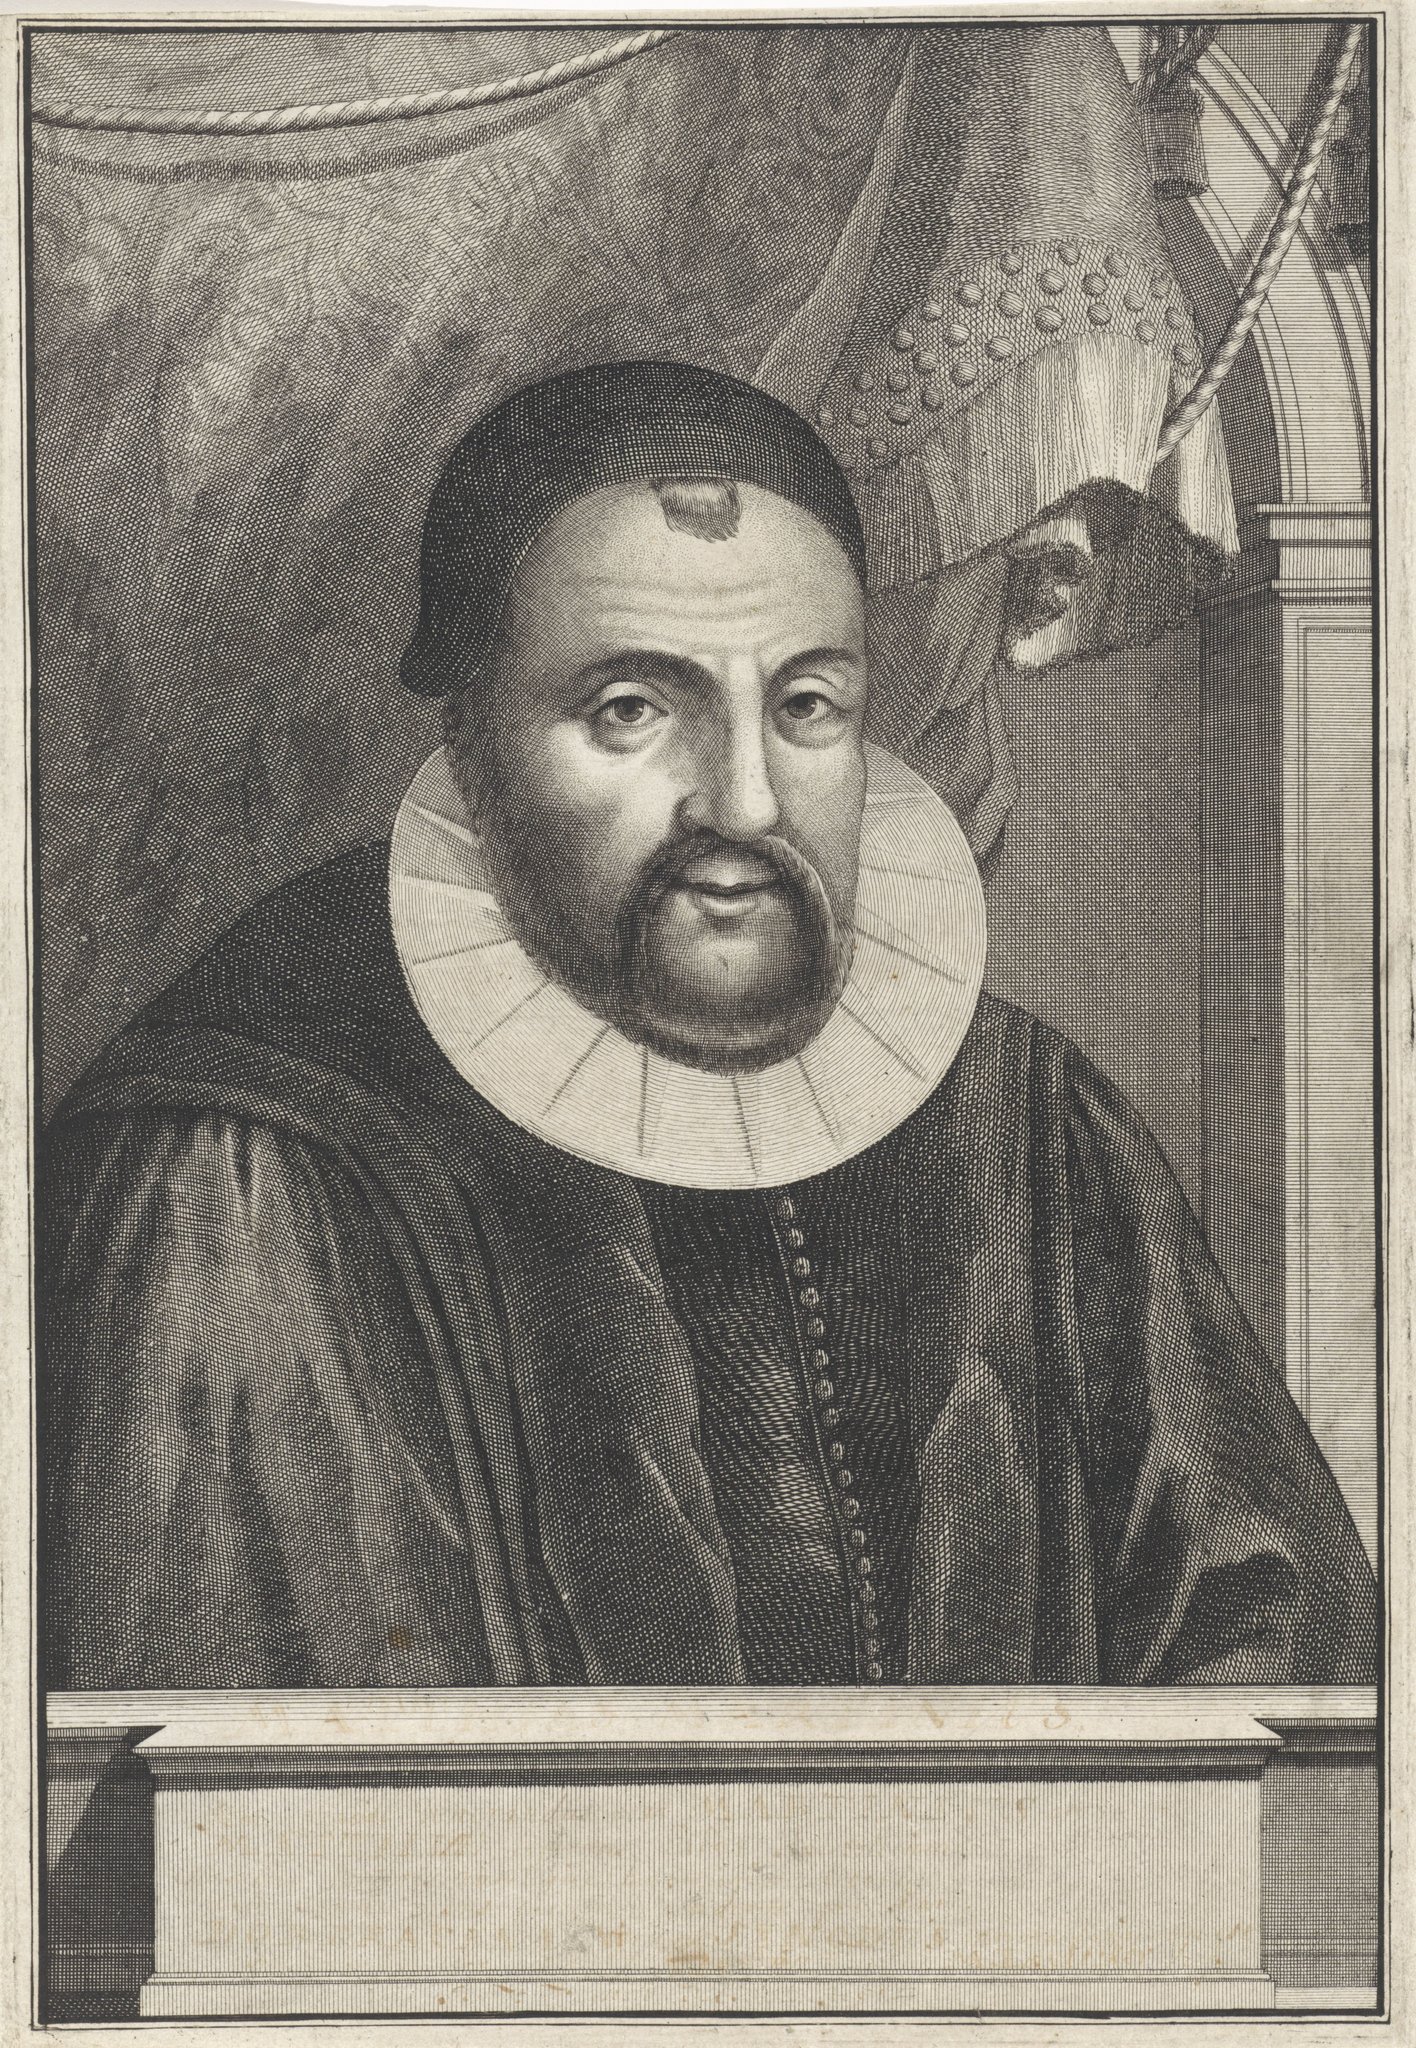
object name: print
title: Portret van Matthias Martinius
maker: jan van vianen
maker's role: print maker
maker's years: 1660-1726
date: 1710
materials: paper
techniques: engraving, etching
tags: theoloog, filoloog, matthias martinius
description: Latere staat prent ook gebruikt als boekillustatie in: Martinius, Matthias. Lexicon philologicum. 2 dln. Utrecht: Willem Broedelet, 1710.